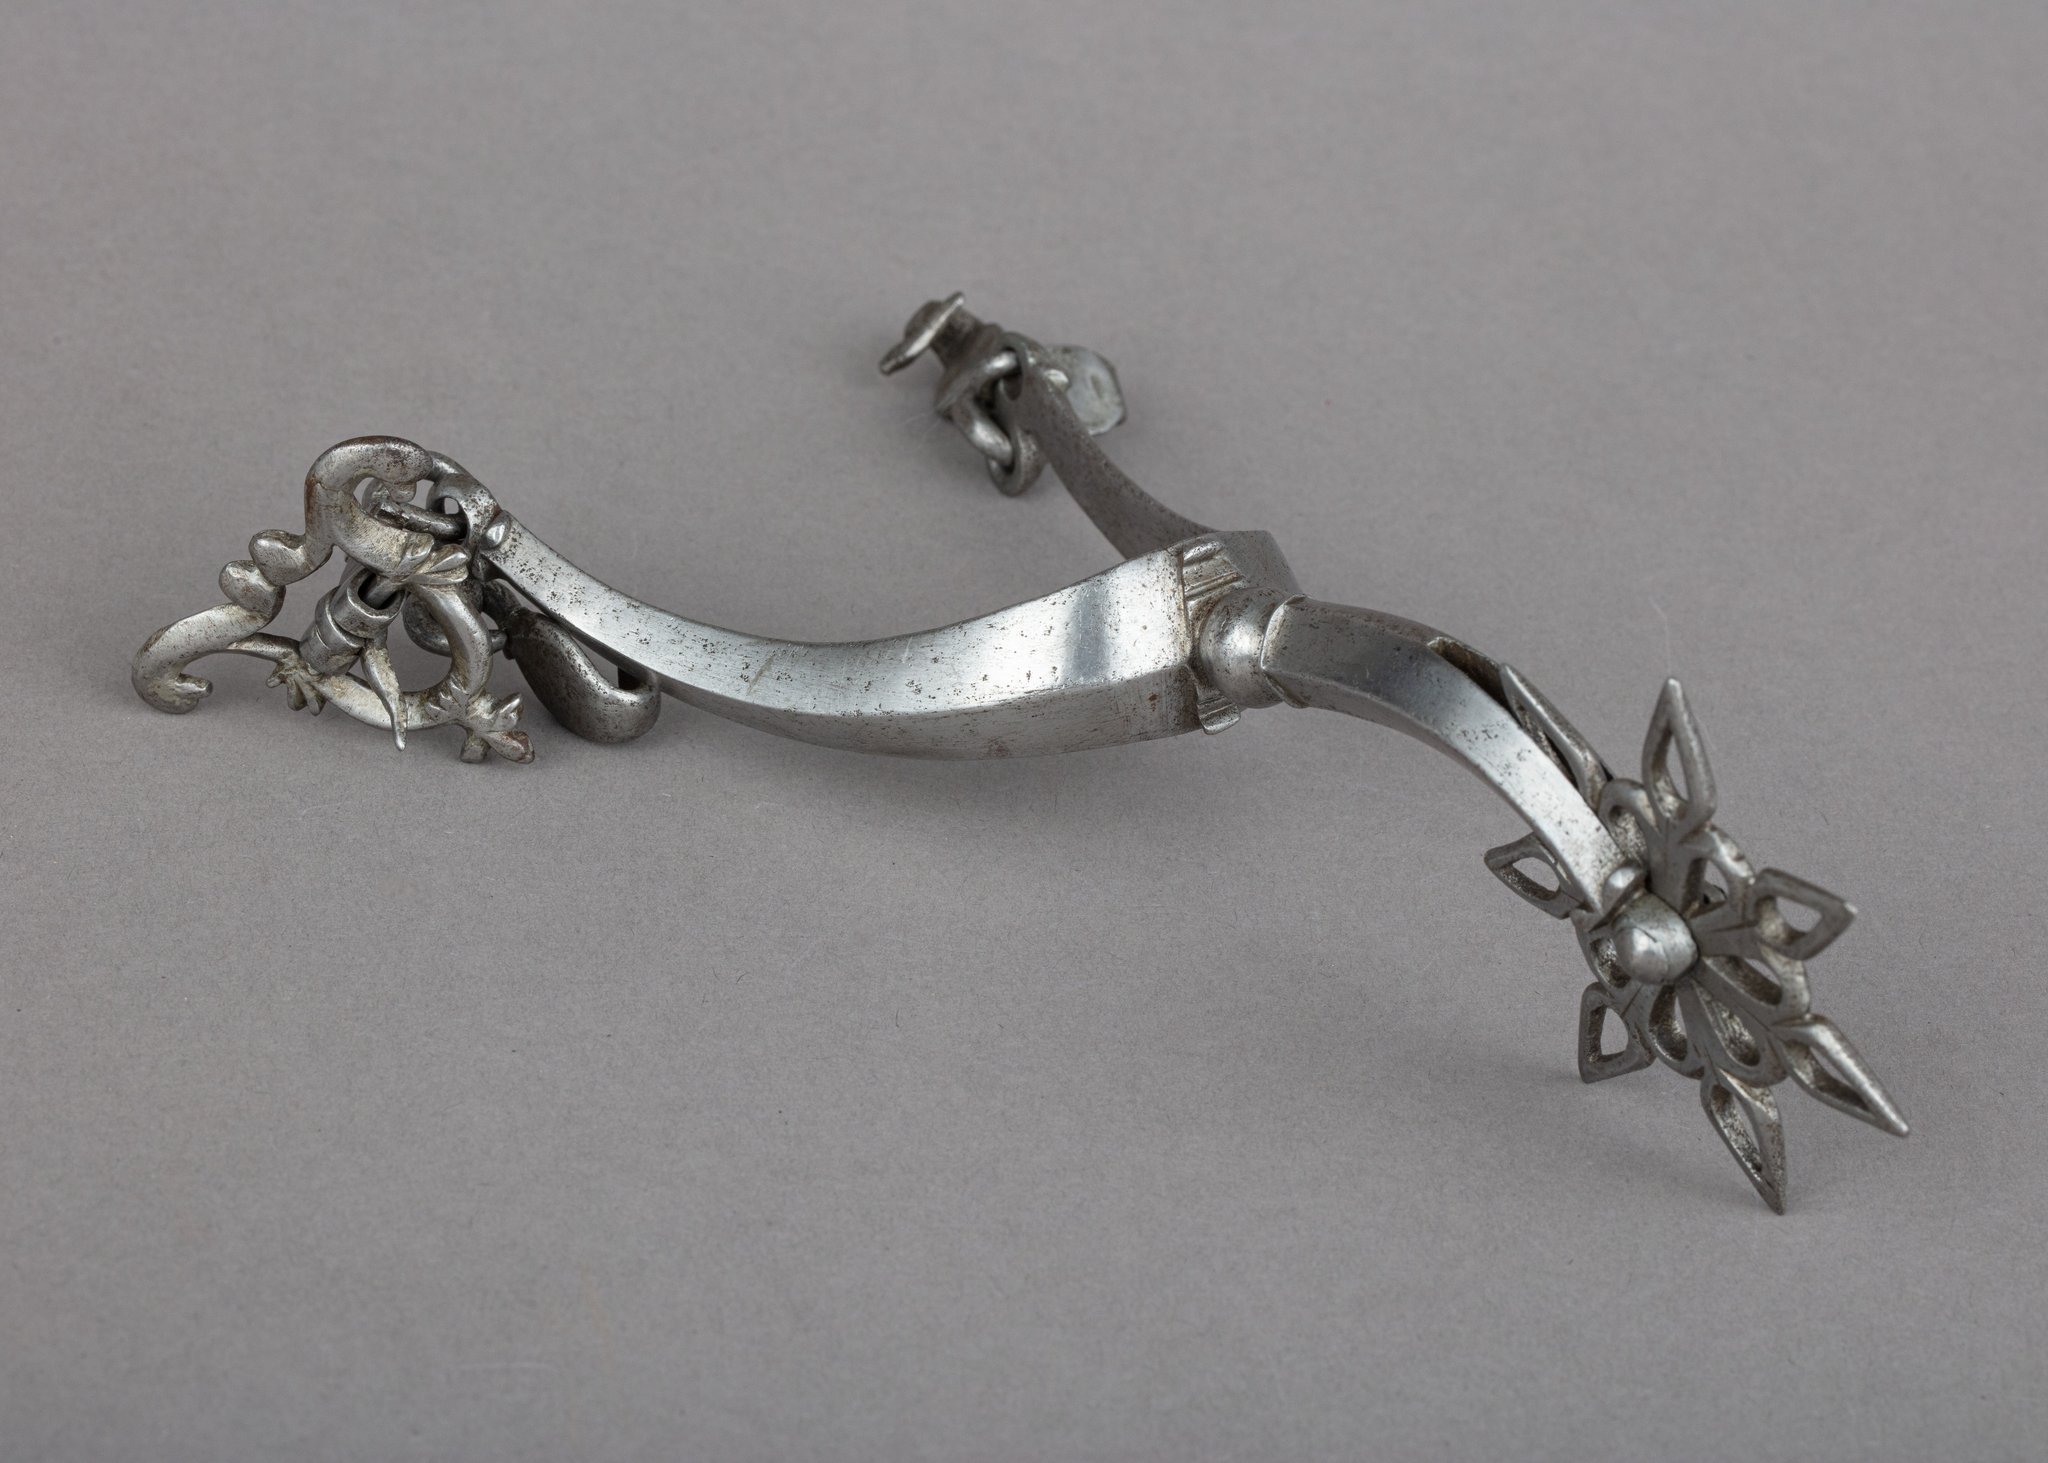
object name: spur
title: Rowel Spur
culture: european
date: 1601-1633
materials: metal alloy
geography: italy